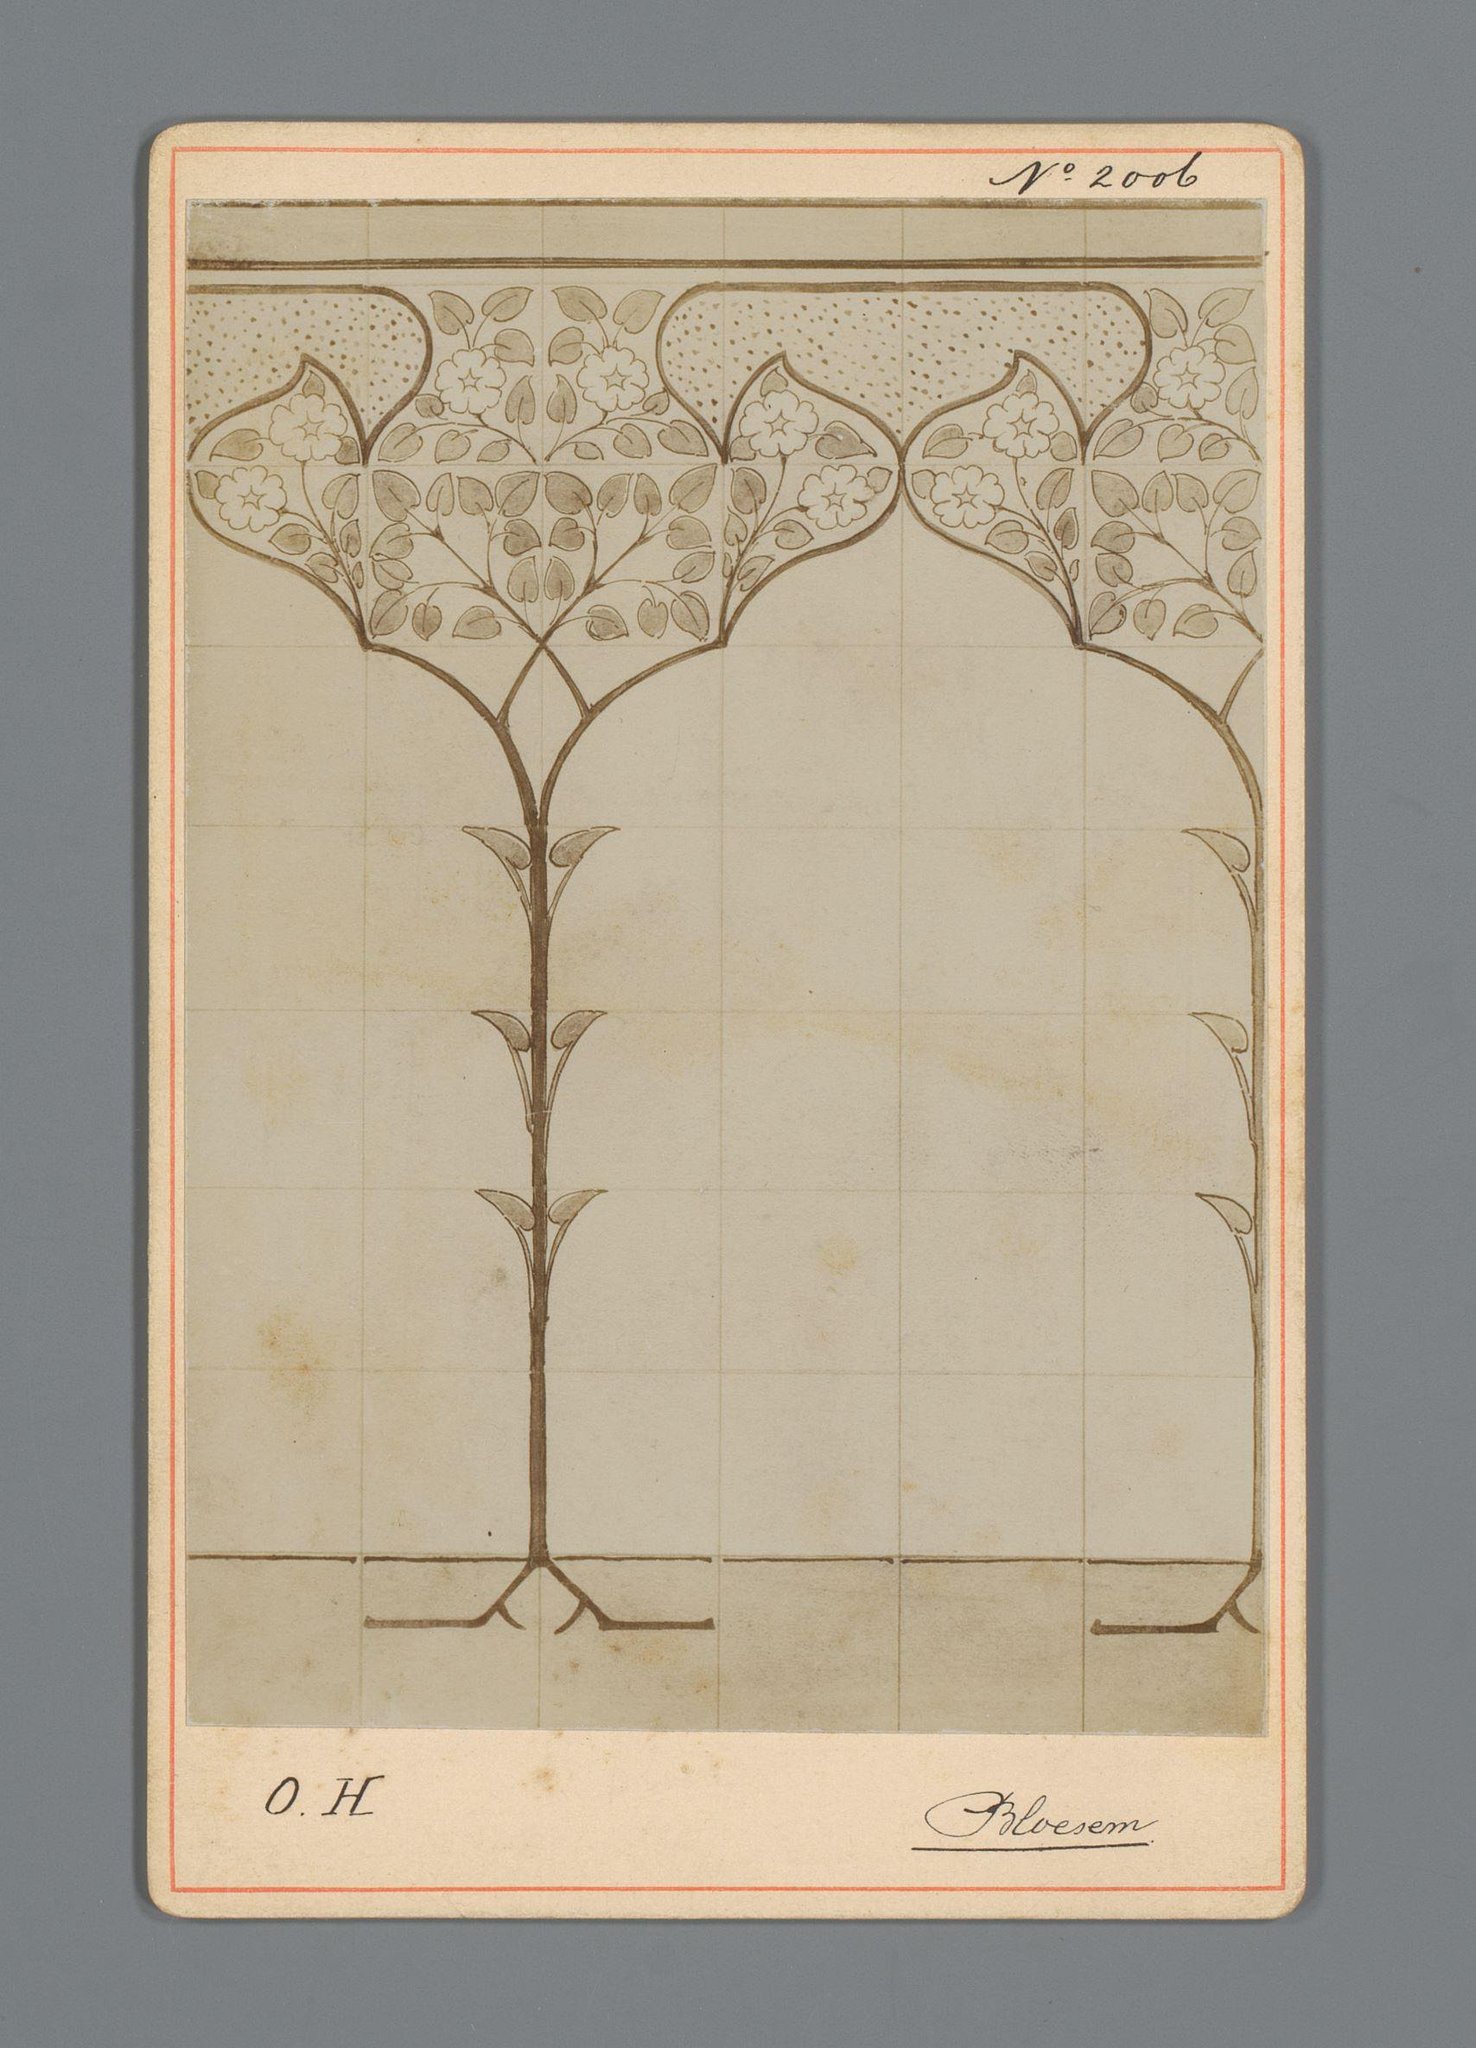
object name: cabinet photograph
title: Tegeltableau met bloesembomen, reclame voor Fayence en Tegelfabriek Holland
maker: Anonymous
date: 1893-1918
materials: cardboard, photographic support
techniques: collodion silver print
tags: trees, tiles, bricks ~ building material, ornament derived from plant forms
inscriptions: inscription: ‘7.15 - Fay/ f 19 -per U/ hoog M 1.27 1/2’, stamp: ‘NAAML. VENN. FAYENCE EN TEGELFABRIEK/ "HOLLAND"’, inscription: ‘O. H’, number: ‘No. 2006’